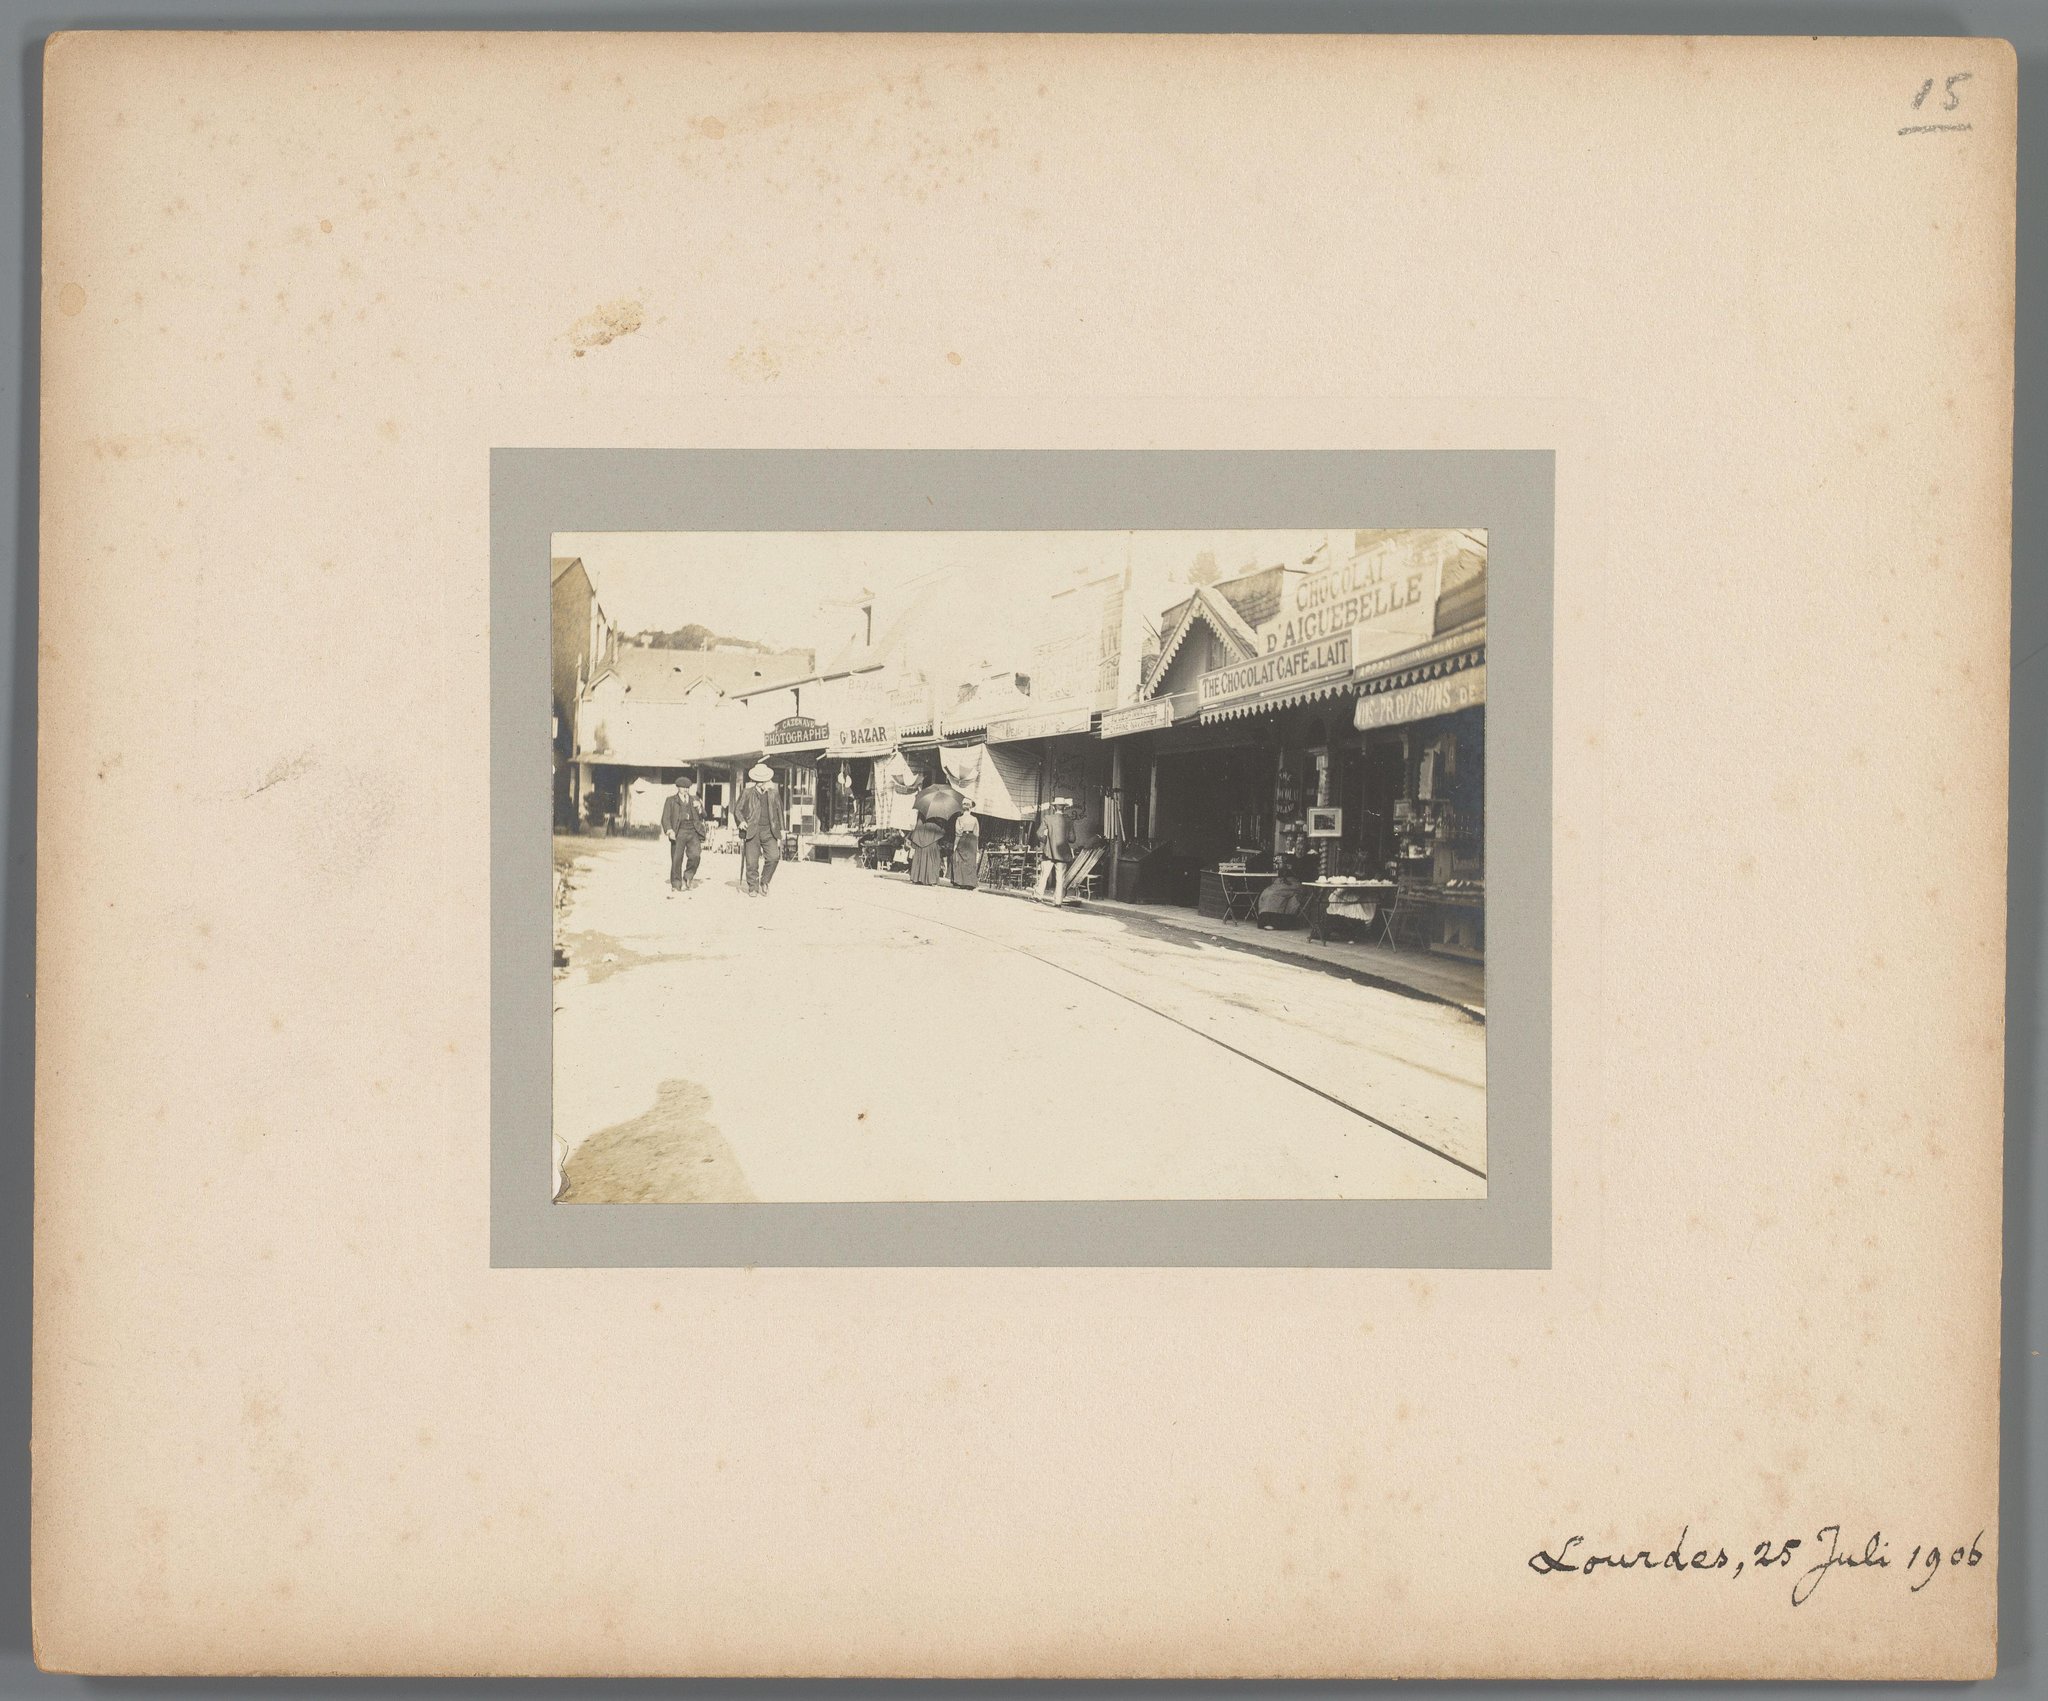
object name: photograph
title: Lourdes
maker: françois buys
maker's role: advocaat, amateurfotograaf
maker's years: 1871-1934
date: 1906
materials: paper, cardboard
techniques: gelatin silver print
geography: lourdes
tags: studio ~ photographer, house combined with shop, street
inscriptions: number: ‘15’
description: Deze foto maakt deel uit van een groep van 49 foto's.